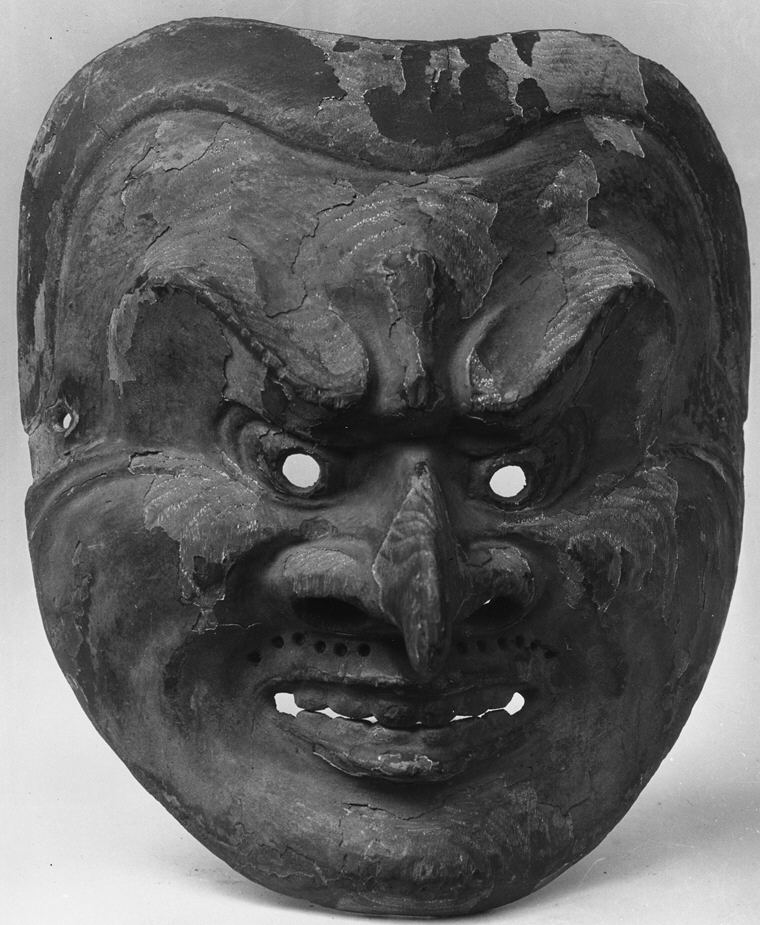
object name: mask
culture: japanese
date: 1185-1333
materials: lacquer, wood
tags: masks